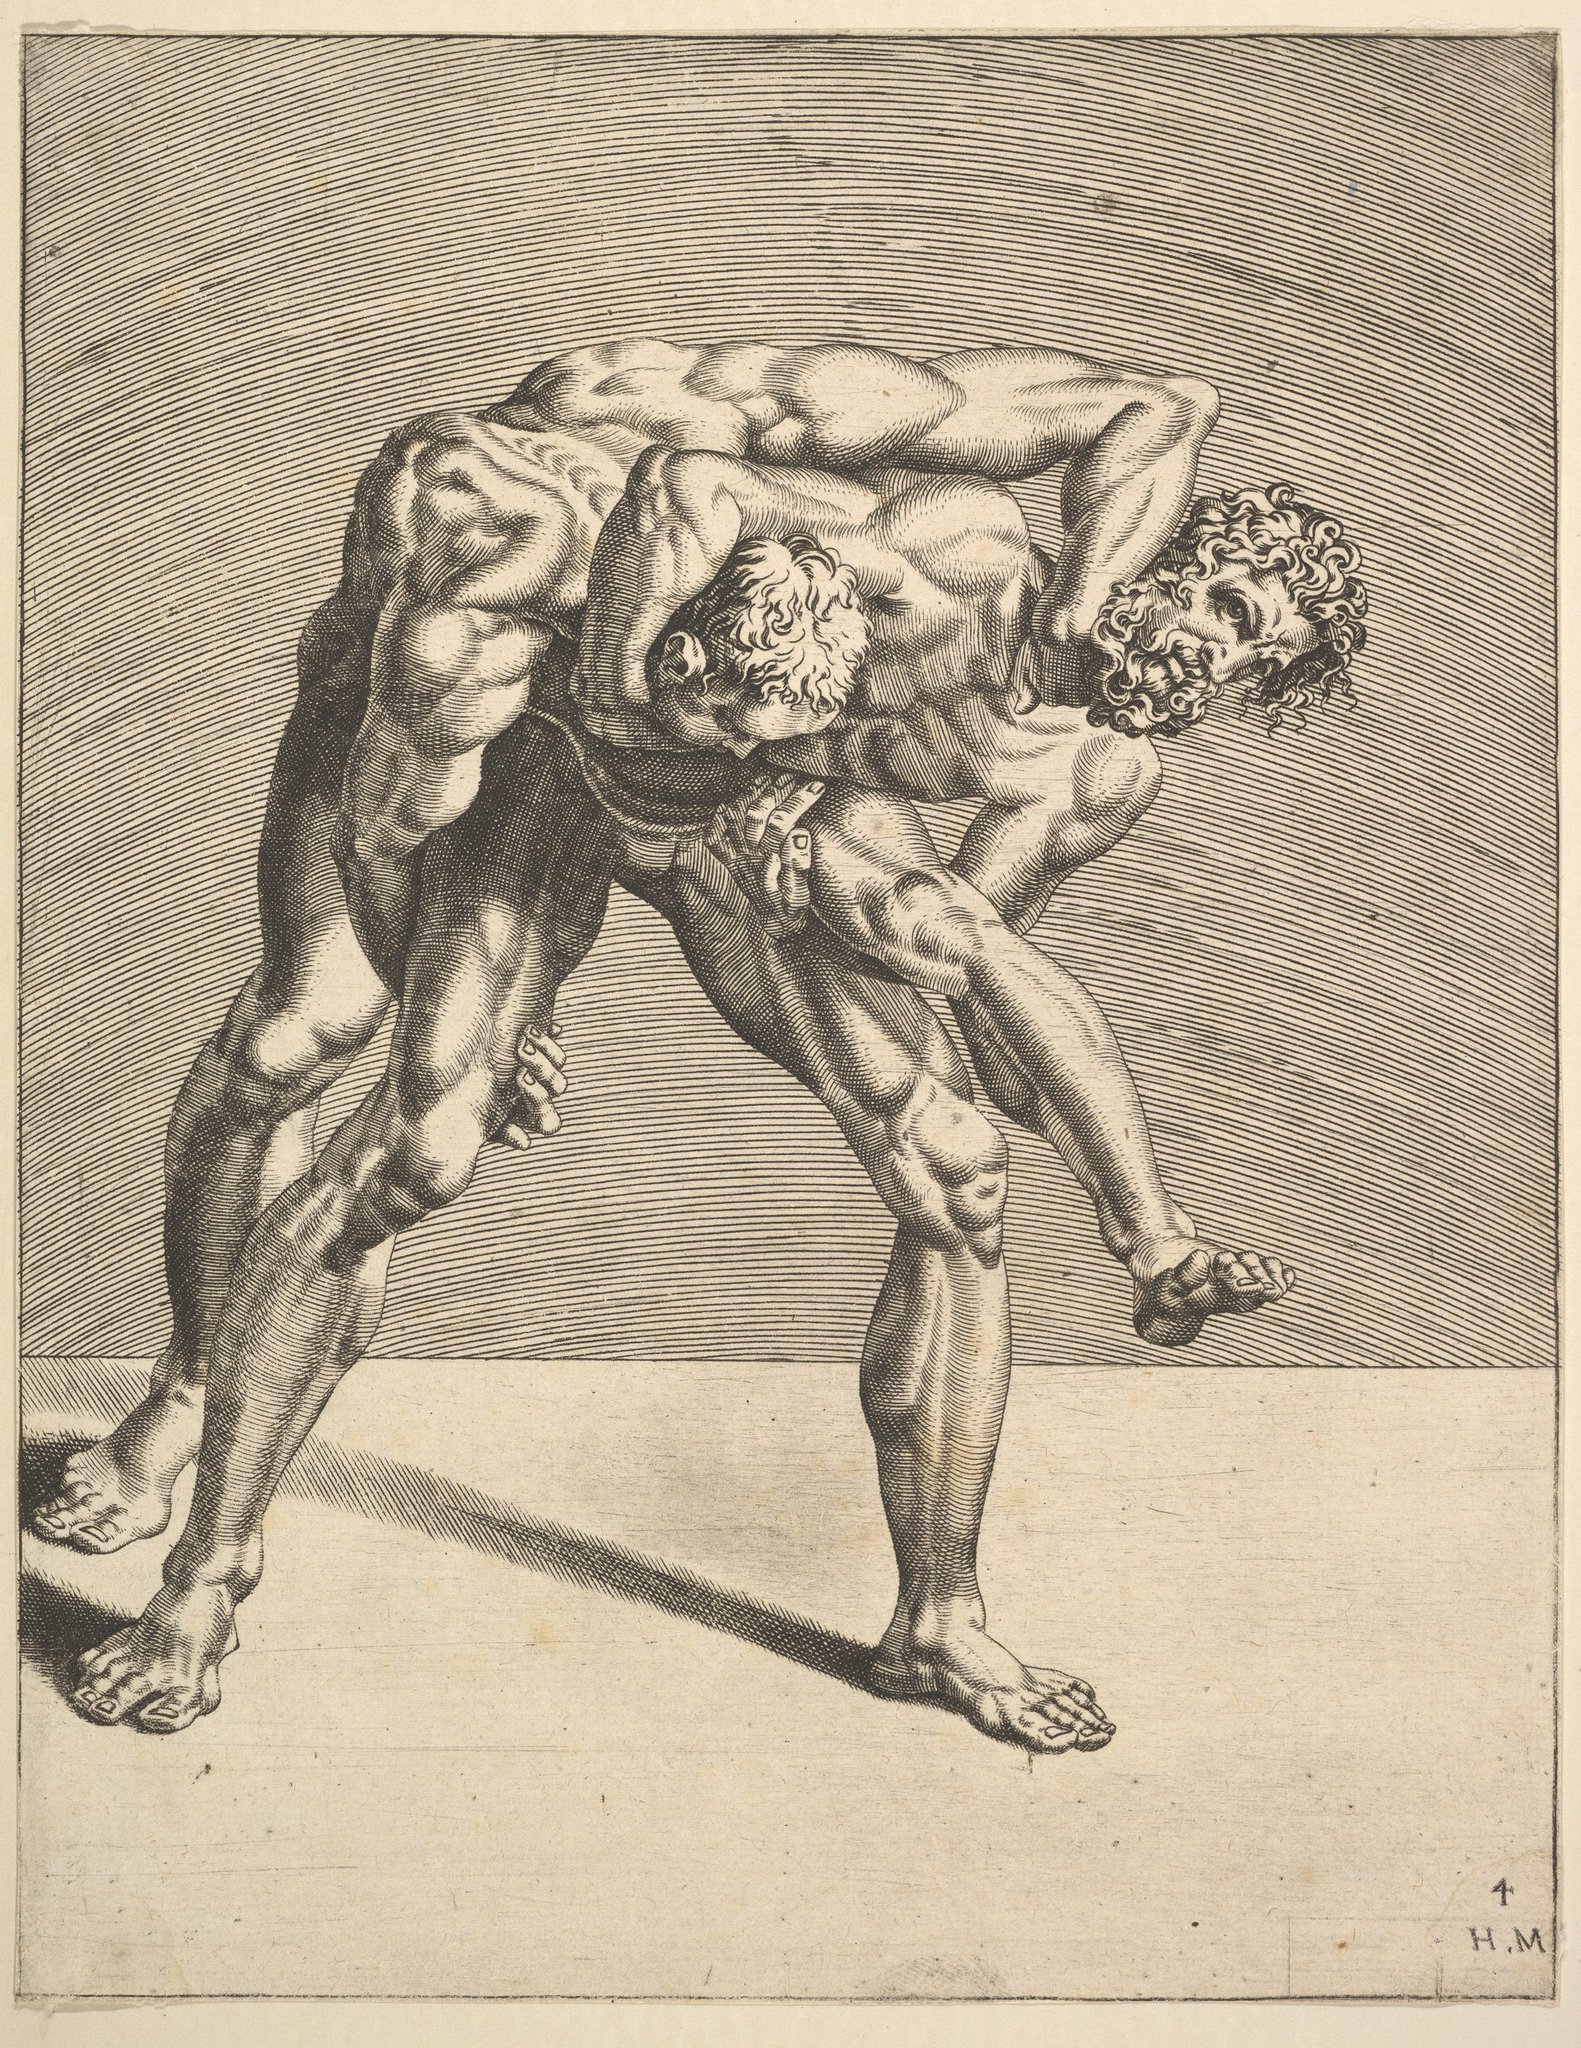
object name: print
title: Two Wrestlers, from Wrestlers, plate 4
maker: dirck volckertsz coornhert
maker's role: artist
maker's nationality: netherlandish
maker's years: 1519-1590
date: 1552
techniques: engraving, etching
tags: men,athletes,wrestling